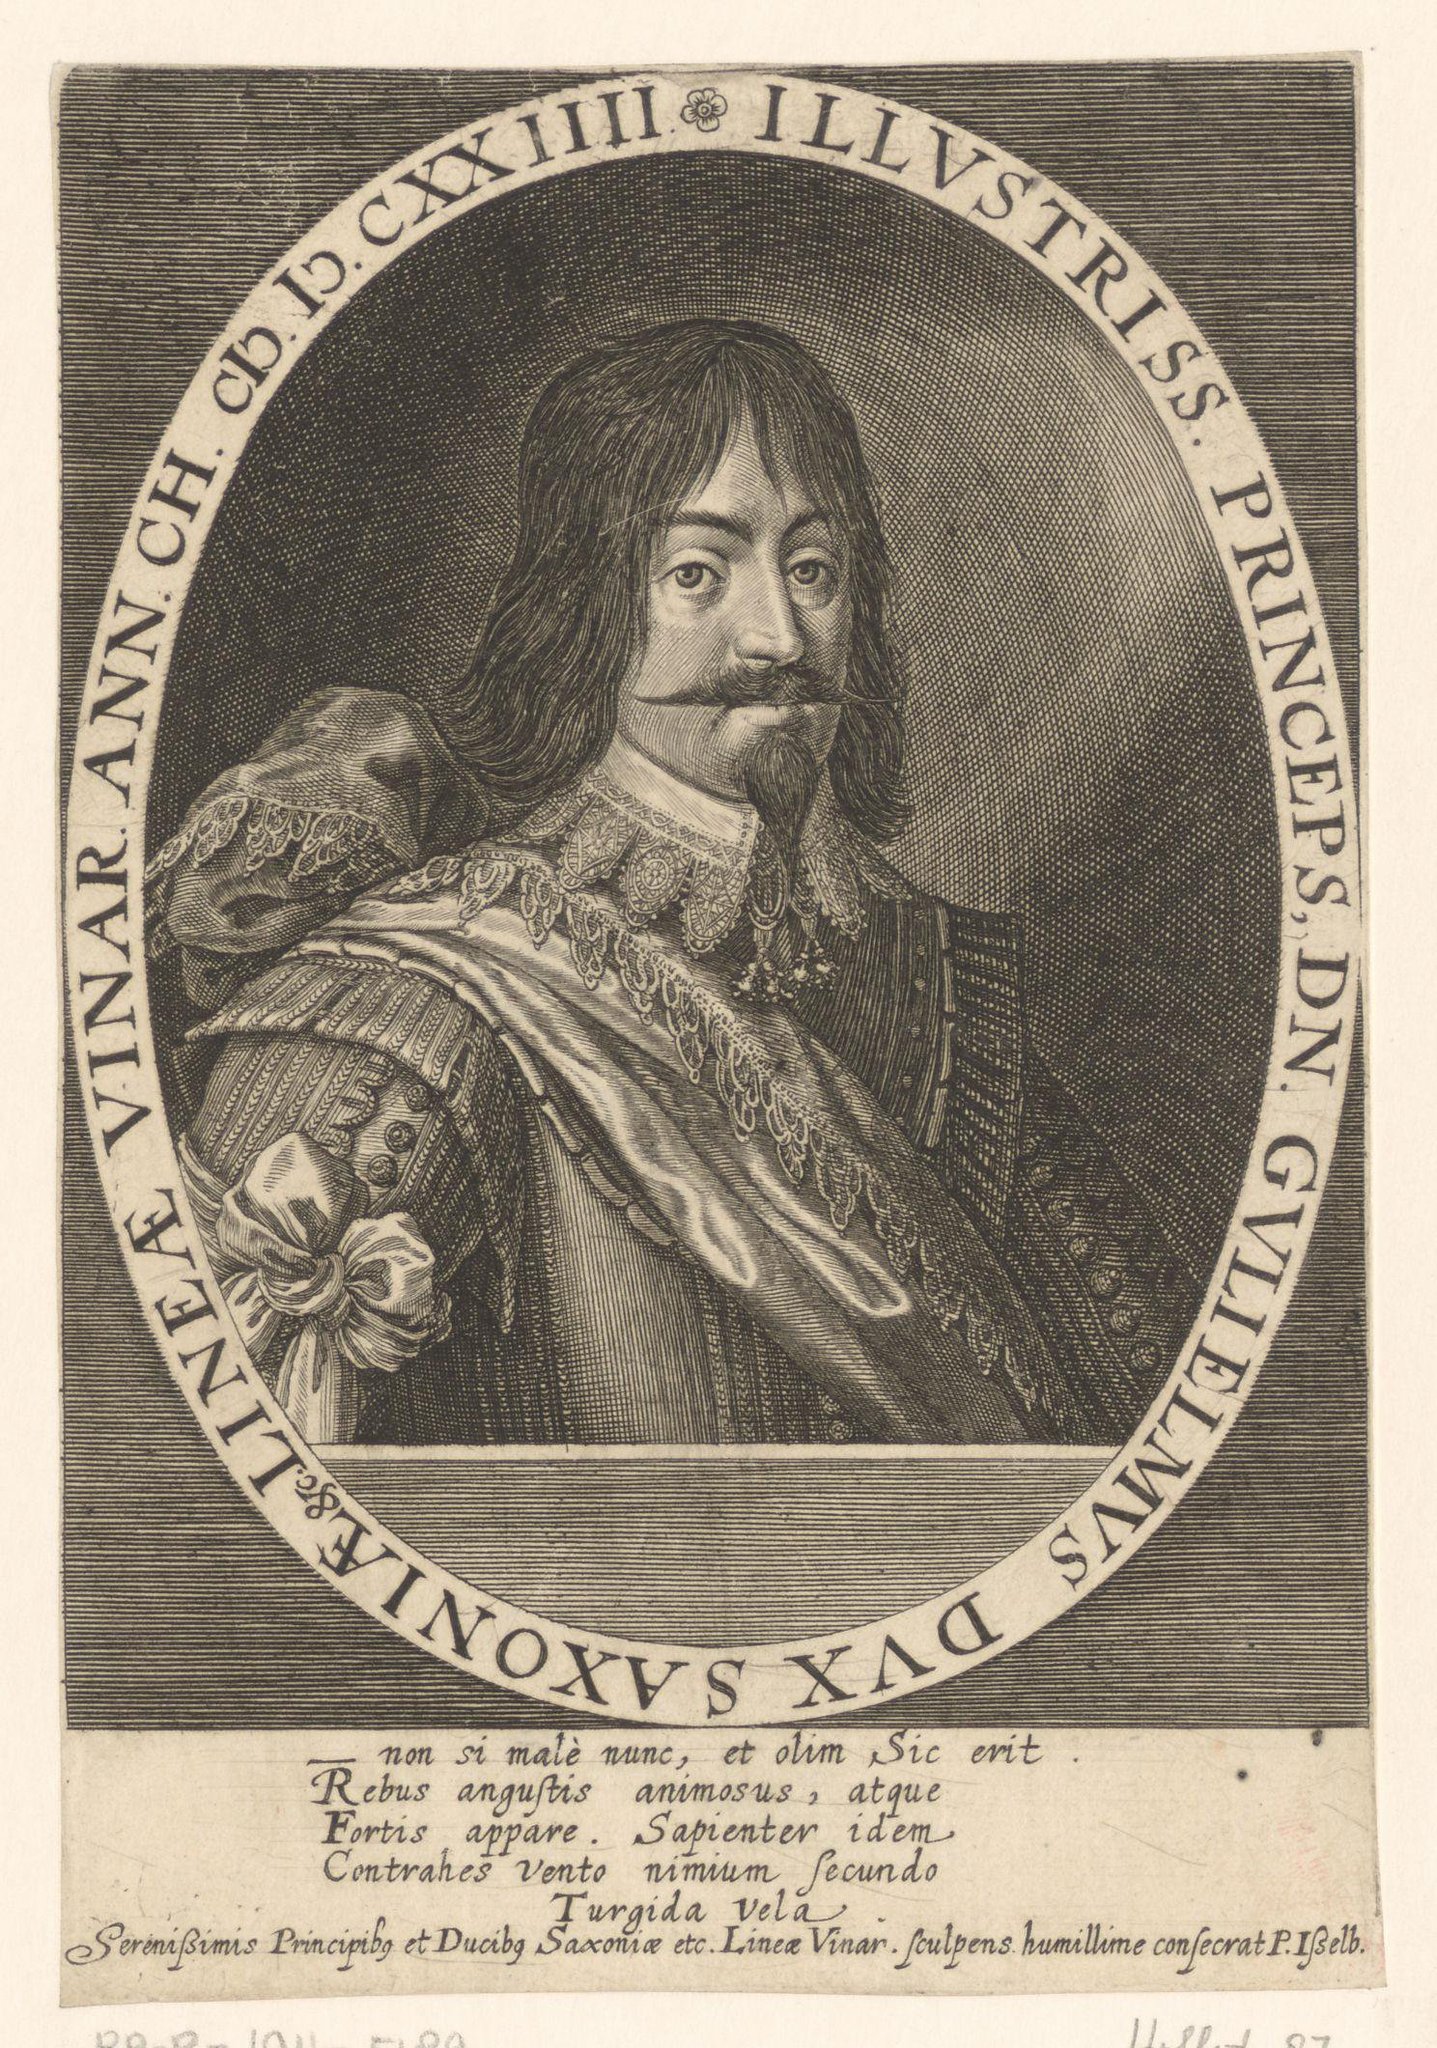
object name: print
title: Portret van Wilhelm IV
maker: peter isselburg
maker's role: print maker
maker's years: 1568-1630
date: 1608-1630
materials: paper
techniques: engraving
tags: commander-in-chief, general, marshal, historical persons, politician, e.g. party leader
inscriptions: collector's mark: Lugt 2228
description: Tekst in het Latijn in de omlijsting en in de marge.